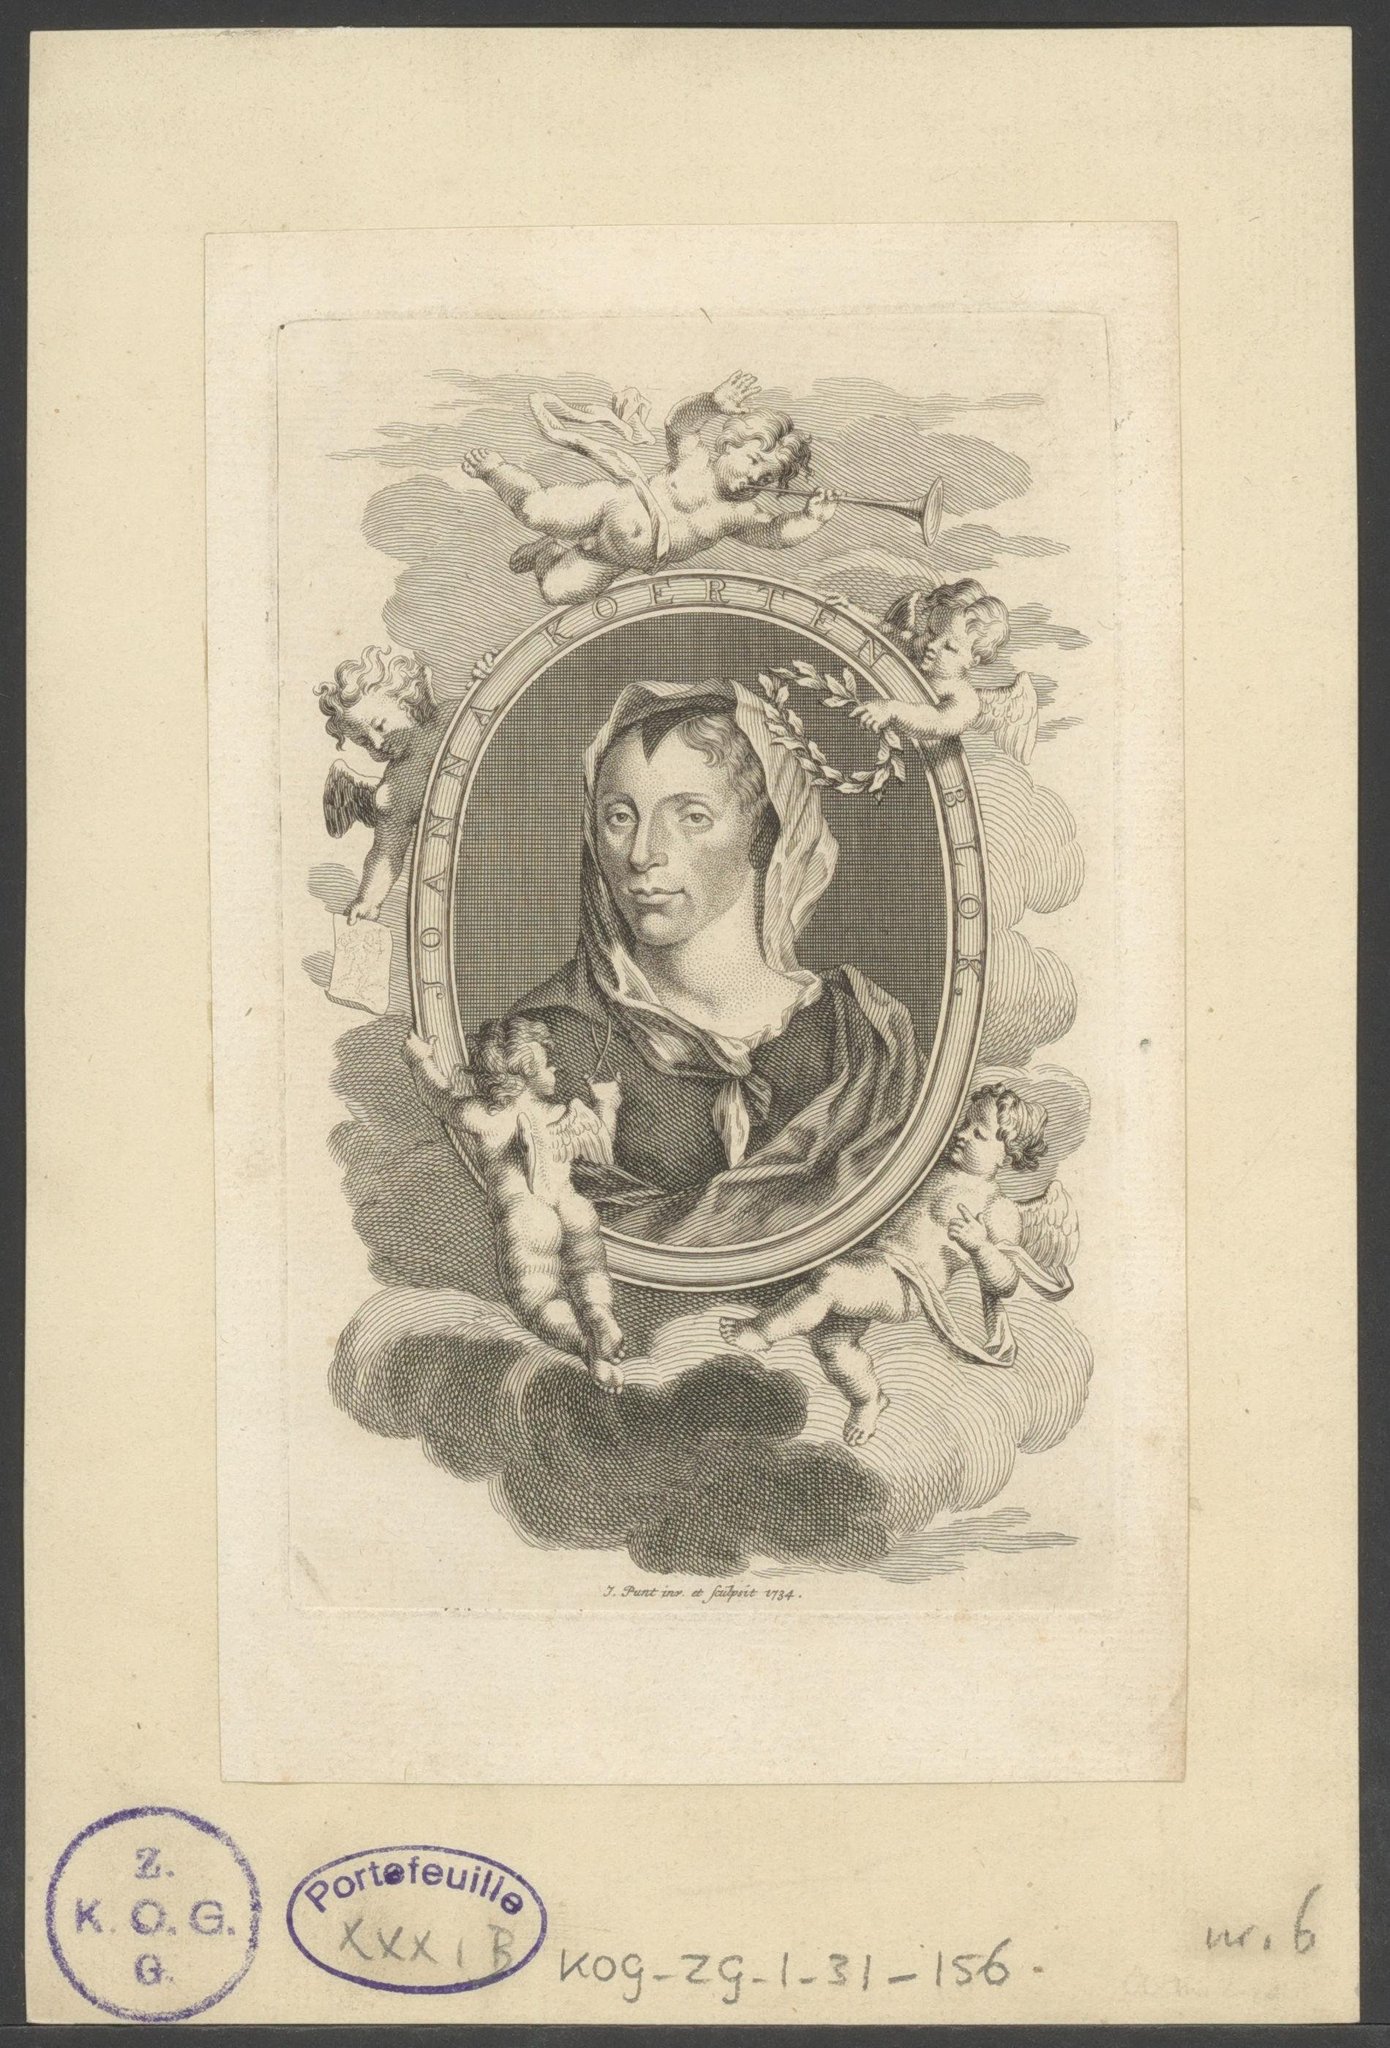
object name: print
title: Portret van papierknipster Johanna Koerten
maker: jan punt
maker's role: draughtsman, print maker, publisher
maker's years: 1711-1779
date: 1734-1735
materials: paper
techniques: engraving, etching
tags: draughtsman, johanna koerten, honouring the artist with laurel wreath, drawing, sketch, historical persons - bb - woman, horn, trumpet, cornet, trombone, tuba, portrait, self-portrait of artist, tools, aids, implements ~ crafts and industries: scissors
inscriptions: stamp, collector's mark: Lugt 1641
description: Haar portret is omringd door vijf putti. Eén van hen blaast de loftrompet. De andere drie hebben respectievelijk een schaar, een tekening en een lauwerkrans in de handen, en de laatste wijst naar haar beeltenis. Onderwerpsrubrieken binnen de Atlas Zeden en Gewoonten: Portretten, Portretten van bijzondere personen.